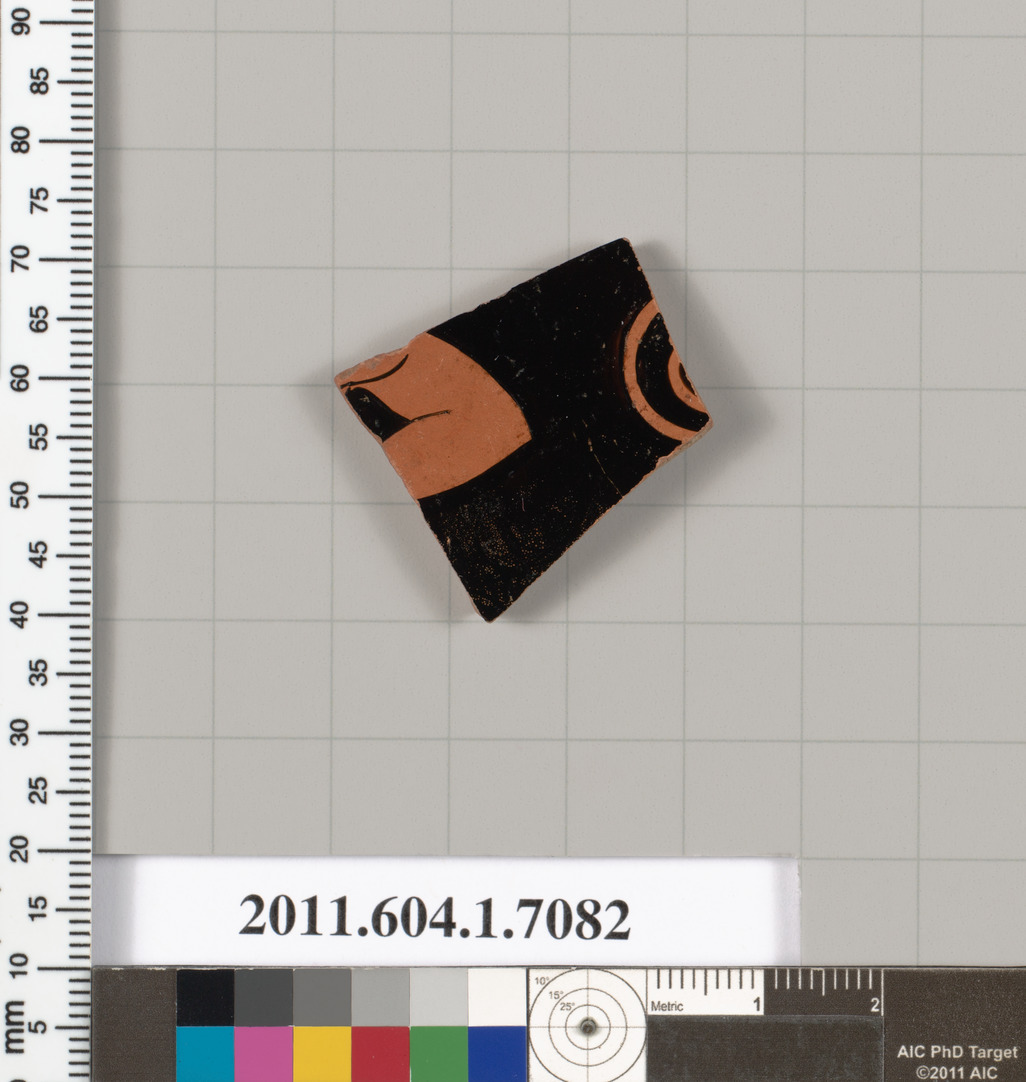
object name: kylix fragment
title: Terracotta fragment of a kylix (drinking cup)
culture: greek, attic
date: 500-480 BCE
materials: terracotta